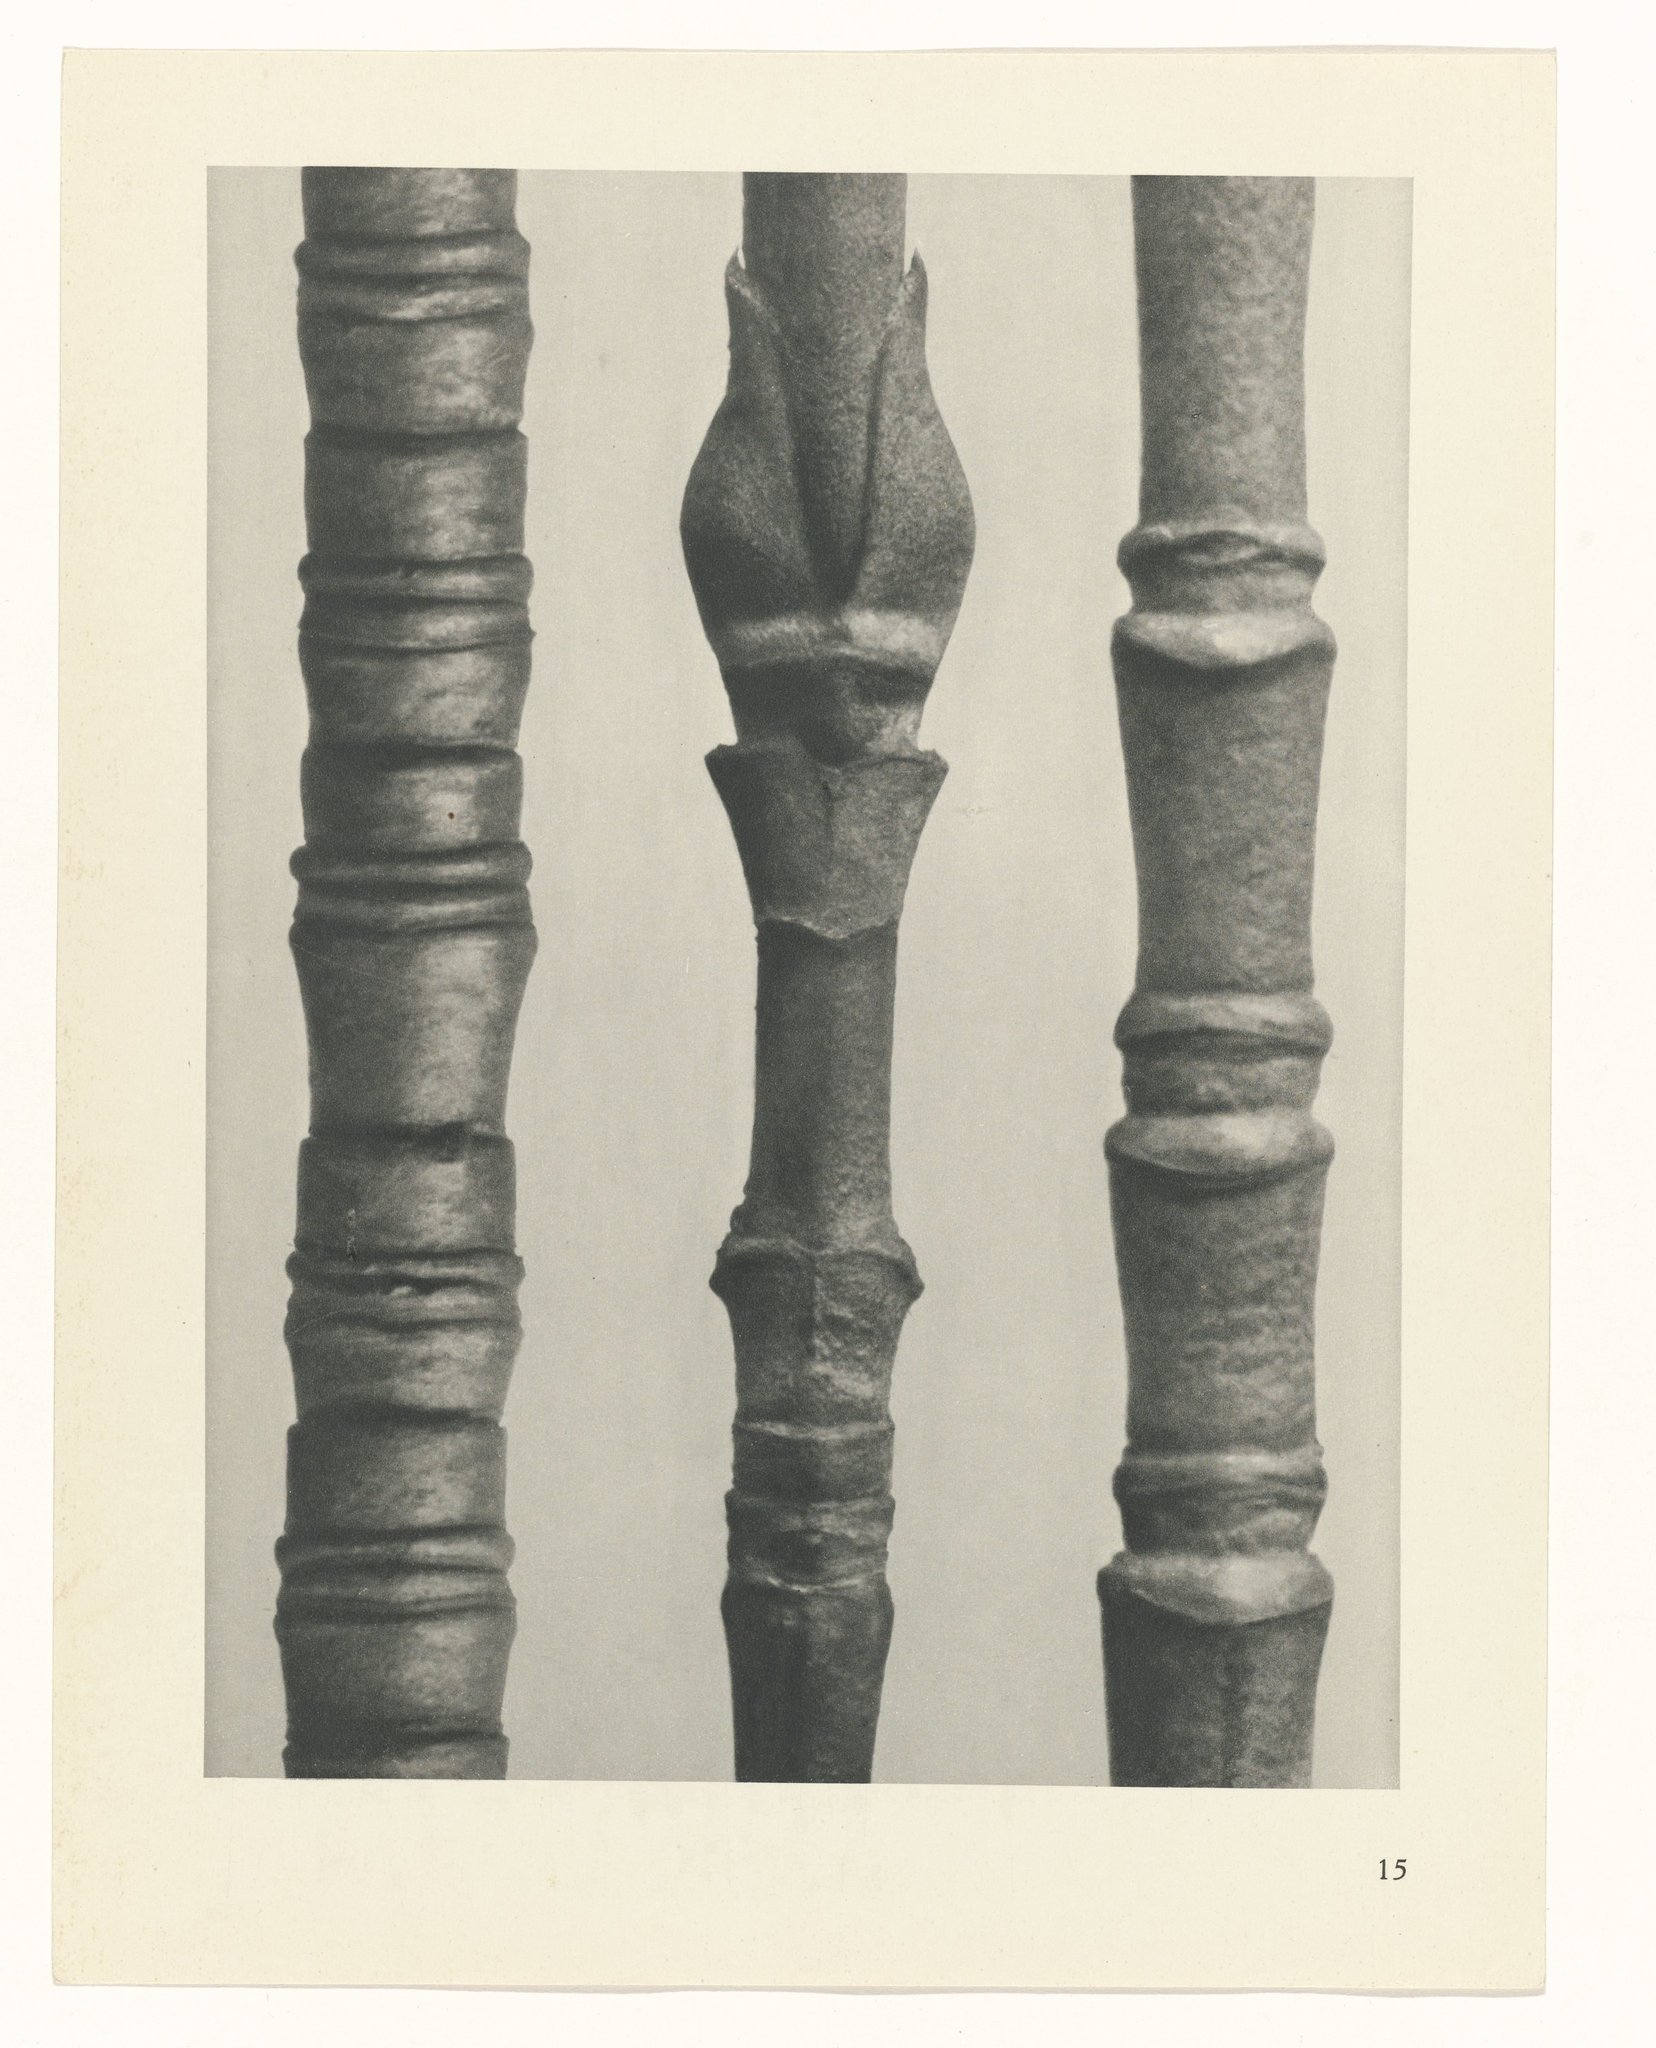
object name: photograph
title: Urformen der Kunst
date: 1928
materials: ink, paper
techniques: rotogravure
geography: berlin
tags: plants (in general)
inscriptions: number: ‘15’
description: facher Vergrößerung. Afkomstig uit losbladige uitgave.